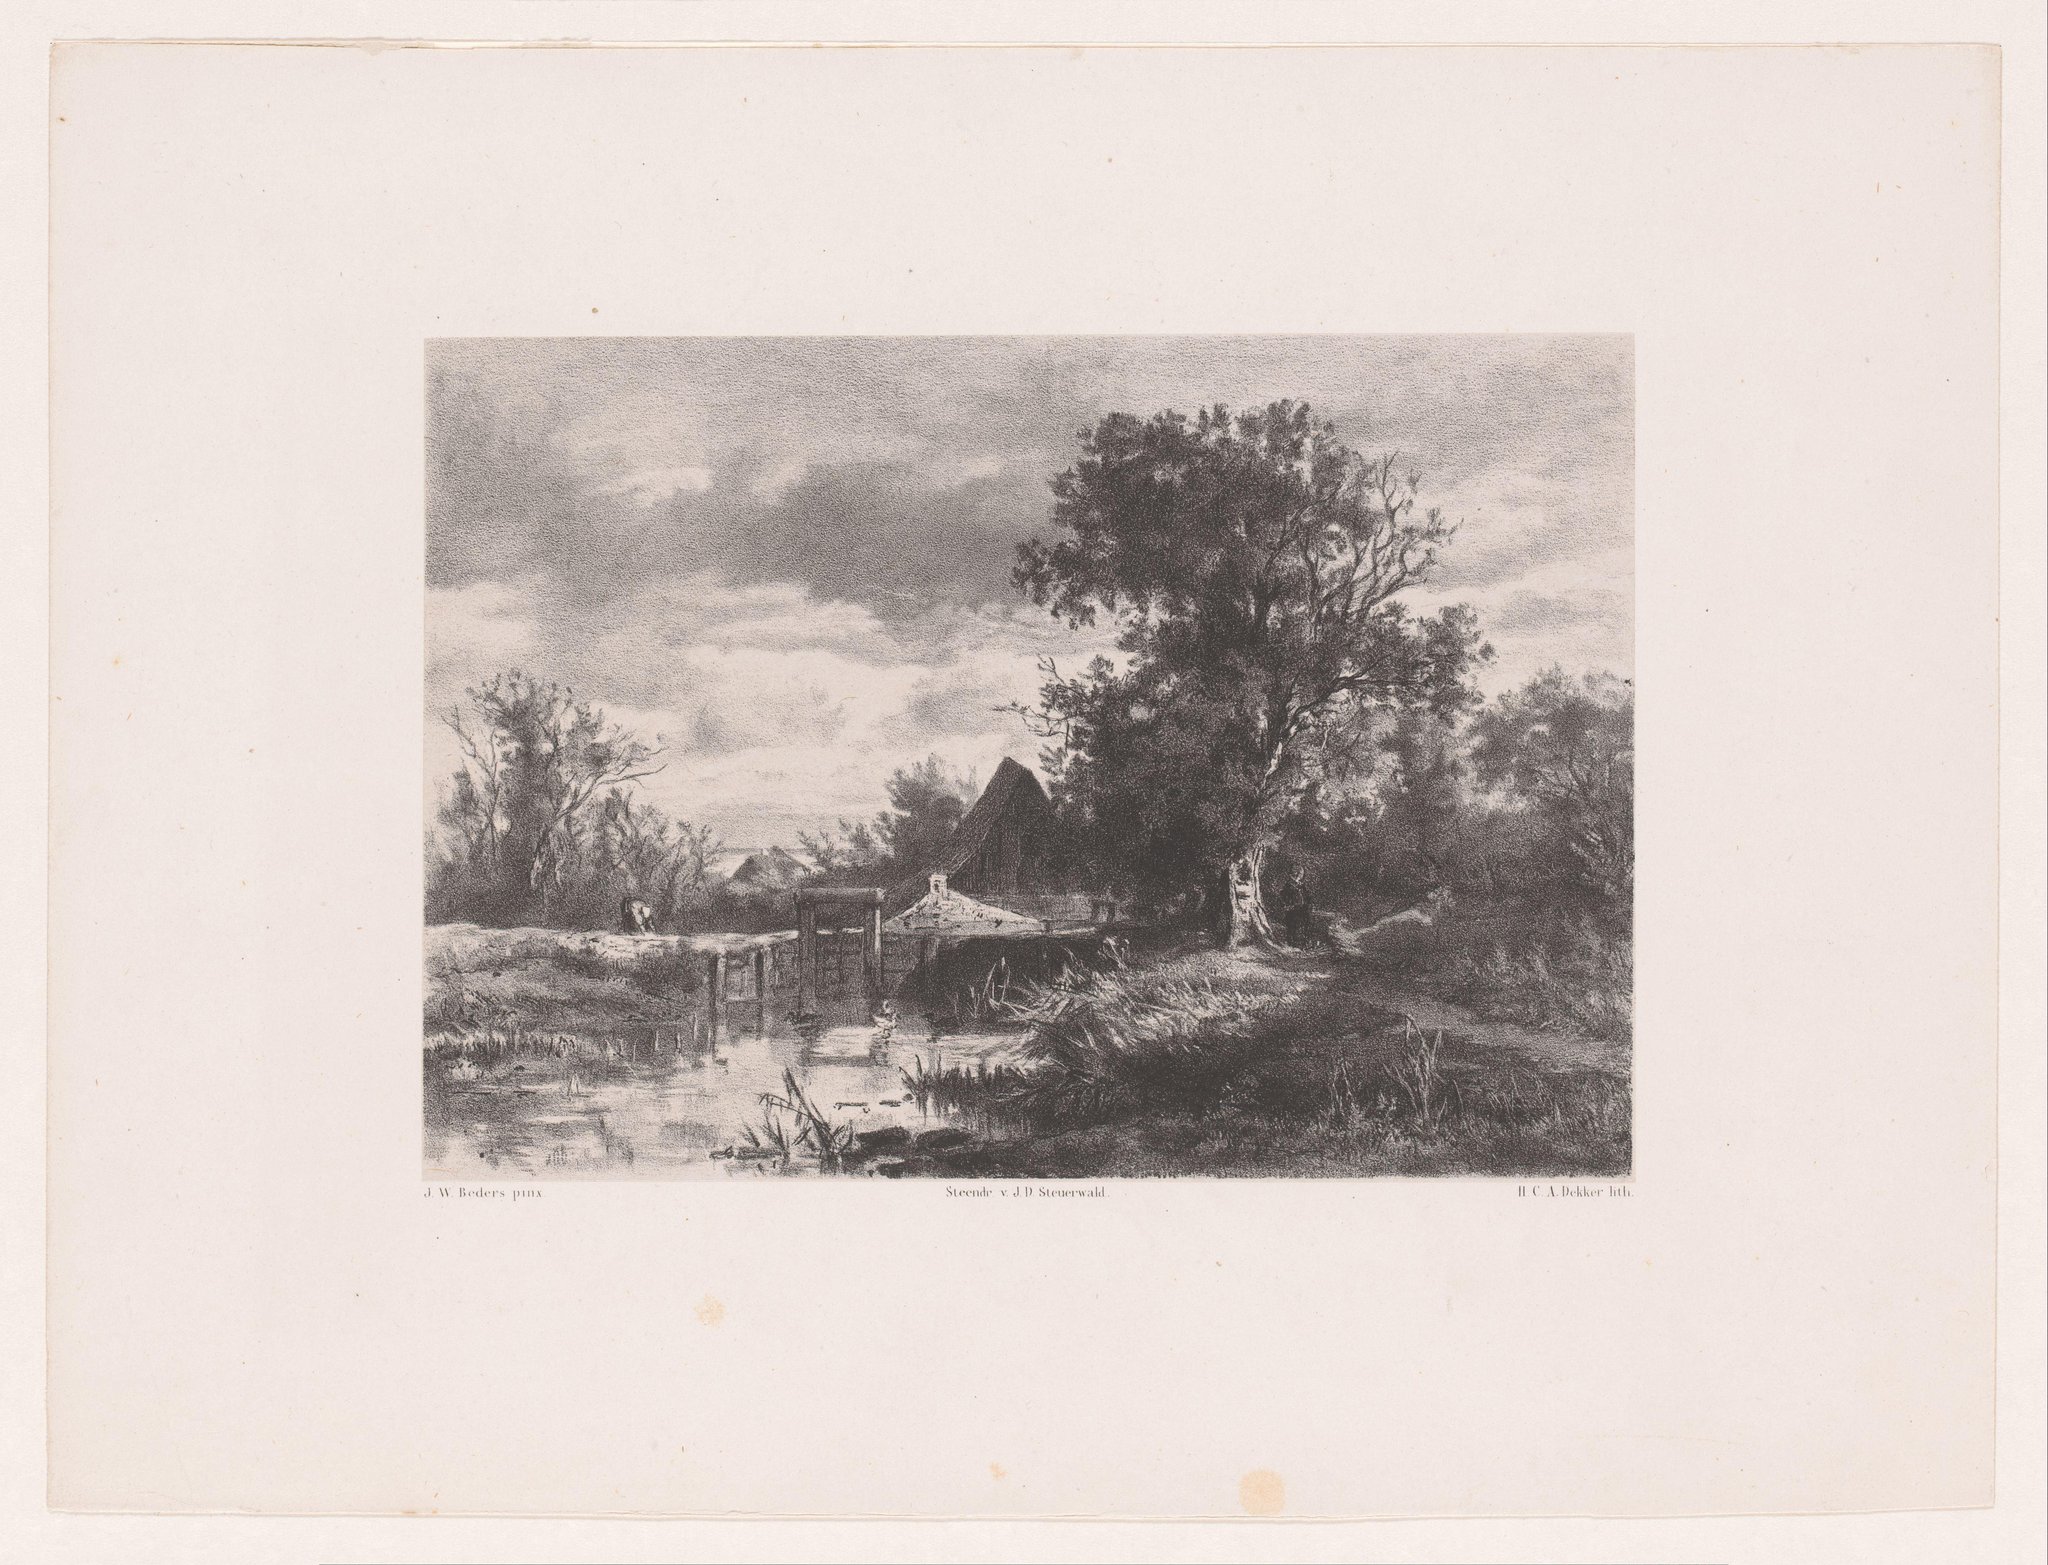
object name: print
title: Landschap met een wetering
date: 1846-1863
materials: paper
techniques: lithograph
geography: amsterdam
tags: sluice, weir (+ landscape with figures, staffage)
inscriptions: collector's mark: Lugt 2228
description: Aan het einde van het water ligt een sluis. Daarachter enkele woningen. Rechts van het water staat een boom, daaronder een figuur.